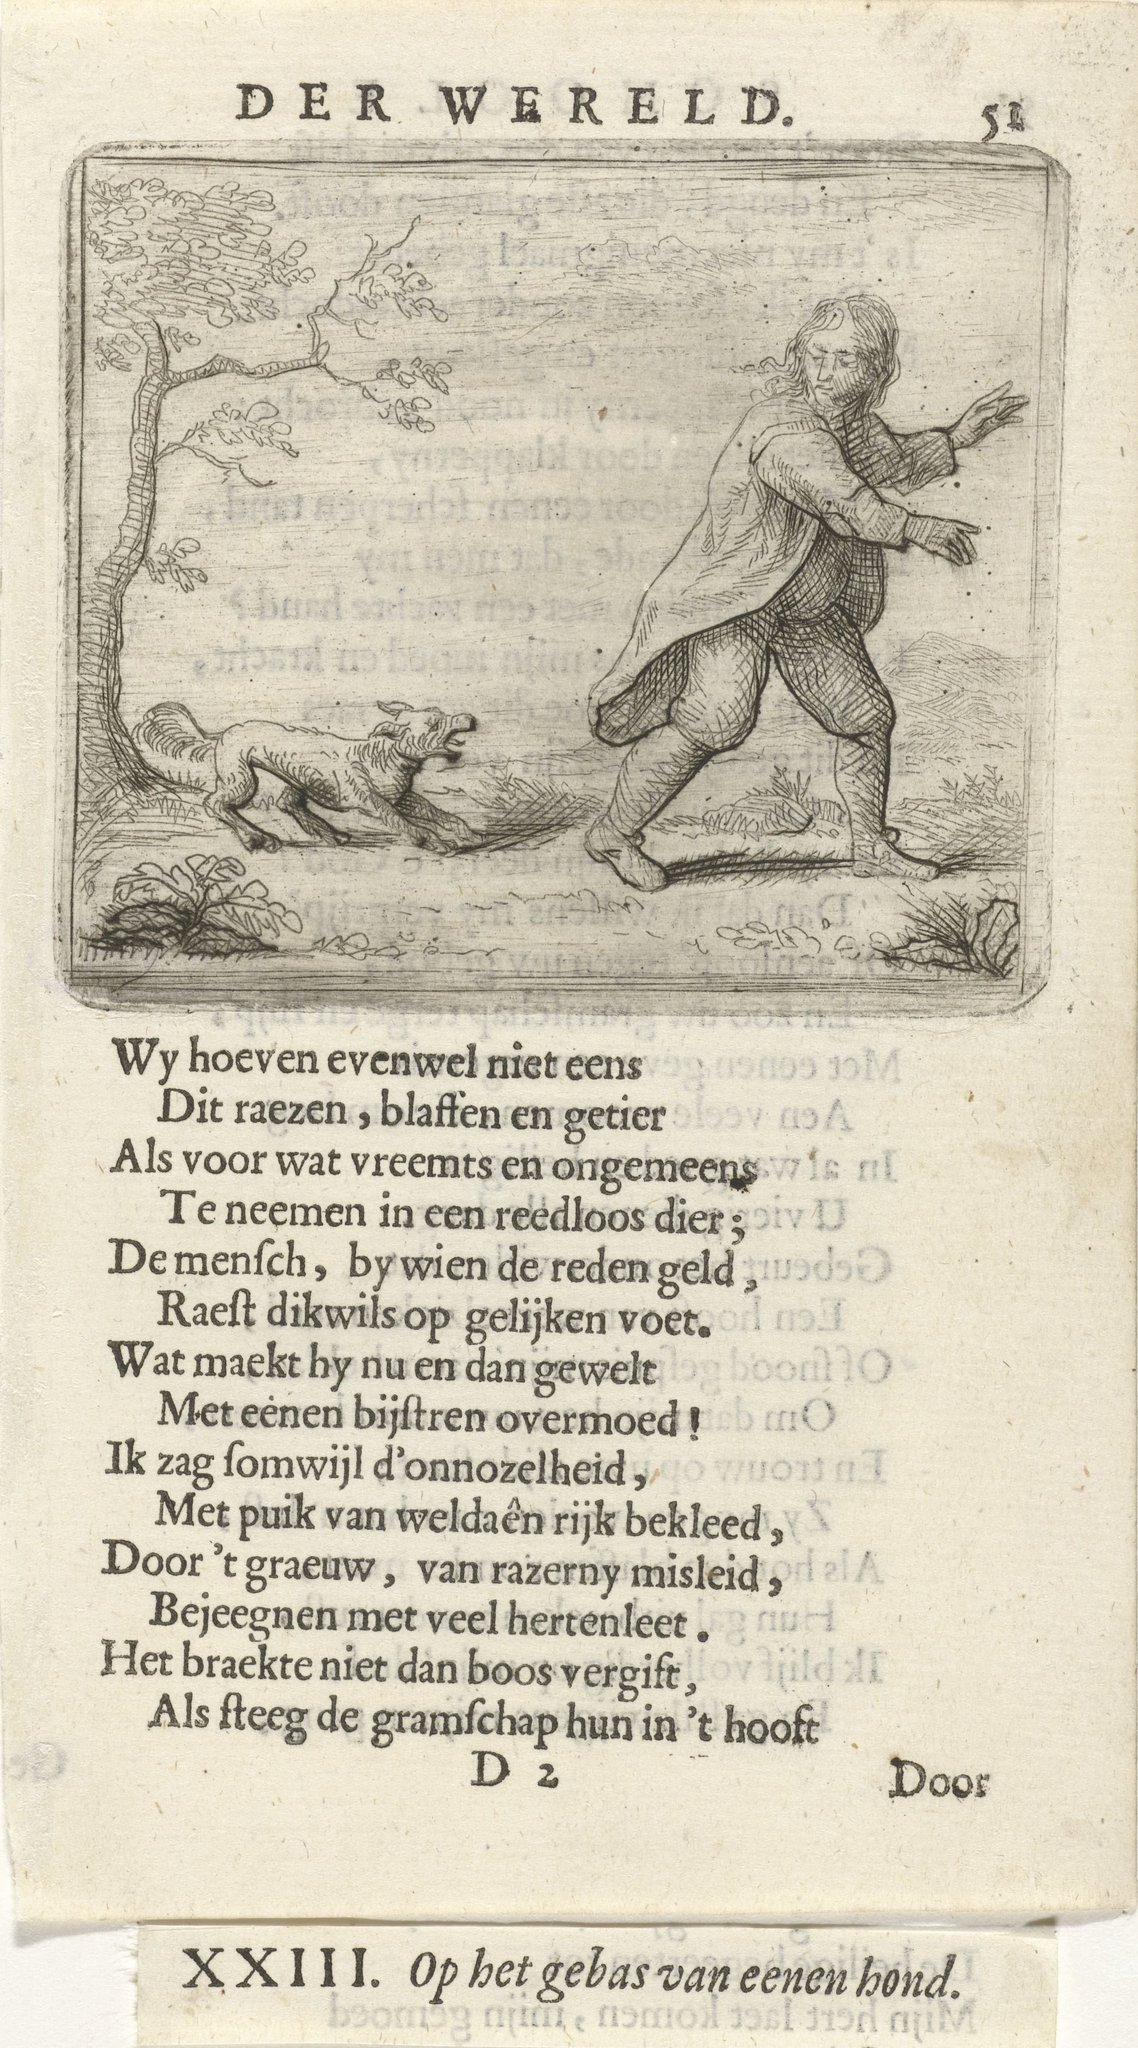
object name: book illustration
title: Man vlucht voor een blaffende hond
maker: arnold houbraken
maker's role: draughtsman, painter, print maker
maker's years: 1660-1719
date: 1682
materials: paper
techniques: etching, letterpress printing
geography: northern netherlands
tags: dog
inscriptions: collector's mark: Lugt 2228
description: Prent uit: Joseph Hall, [bewerkt door] François van Hoogstraeten, De schoole der wereld, geopent in CXL. vliegende bedenkingen op veelerhande voorvallende gezichten en zaeken. Dordrecht: François van Hoogstraeten, 1682. En in herdrukken in 1687 en 1725.